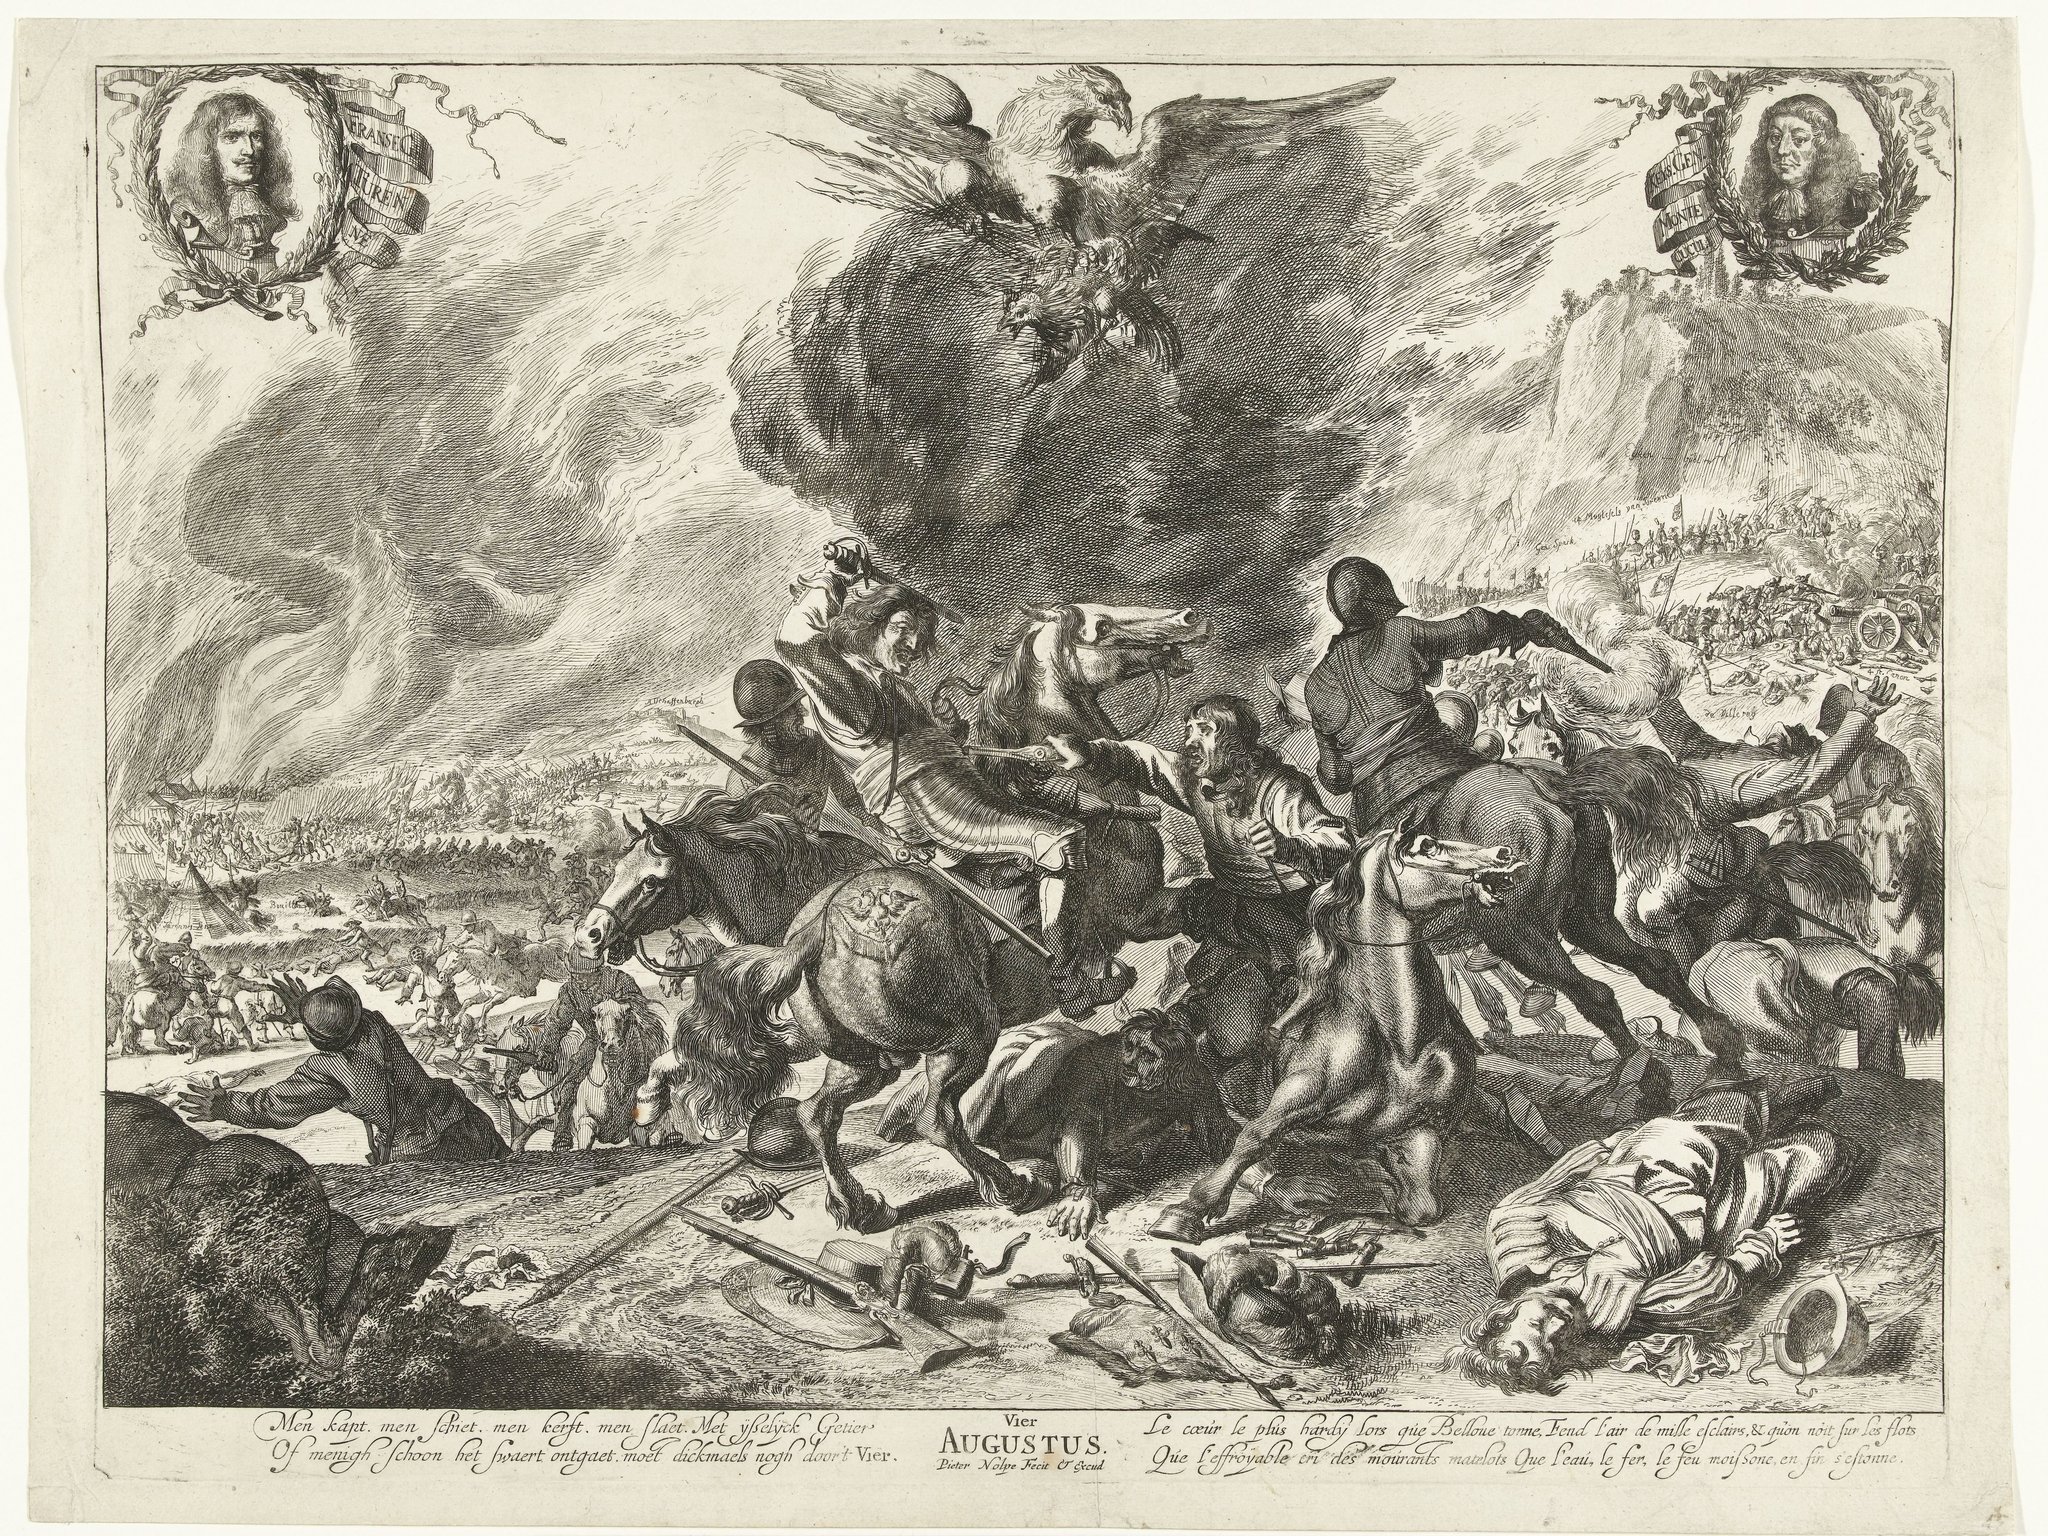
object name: print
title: Gevecht bij Aschaffenburg, 1674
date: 1649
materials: paper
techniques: etching, letterpress printing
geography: northern netherlands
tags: battle (+ land forces)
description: Gevecht bij Aschaffenburg op 4 augustus 1674 tussen het Franse leger onder Turenne en het Oostenrijkse leger onder Montecuccoli. Op de voorgrond een ruitergevecht, daarachter de veldslag met hoge rookwolken, rechts een berg, in de verte Aschaffenburg. Bovenaan portretten van Turenne en Montecuccoli, in het midden grijpt de Oostenrijkse adelaar de Franse haan in de klauwen. In het onderschrift 2 regels in het Nederlands en 2 regels in het Frans, daartussen: Vier Augustus. Bij de prent behoort een tekstblad in twee delen.